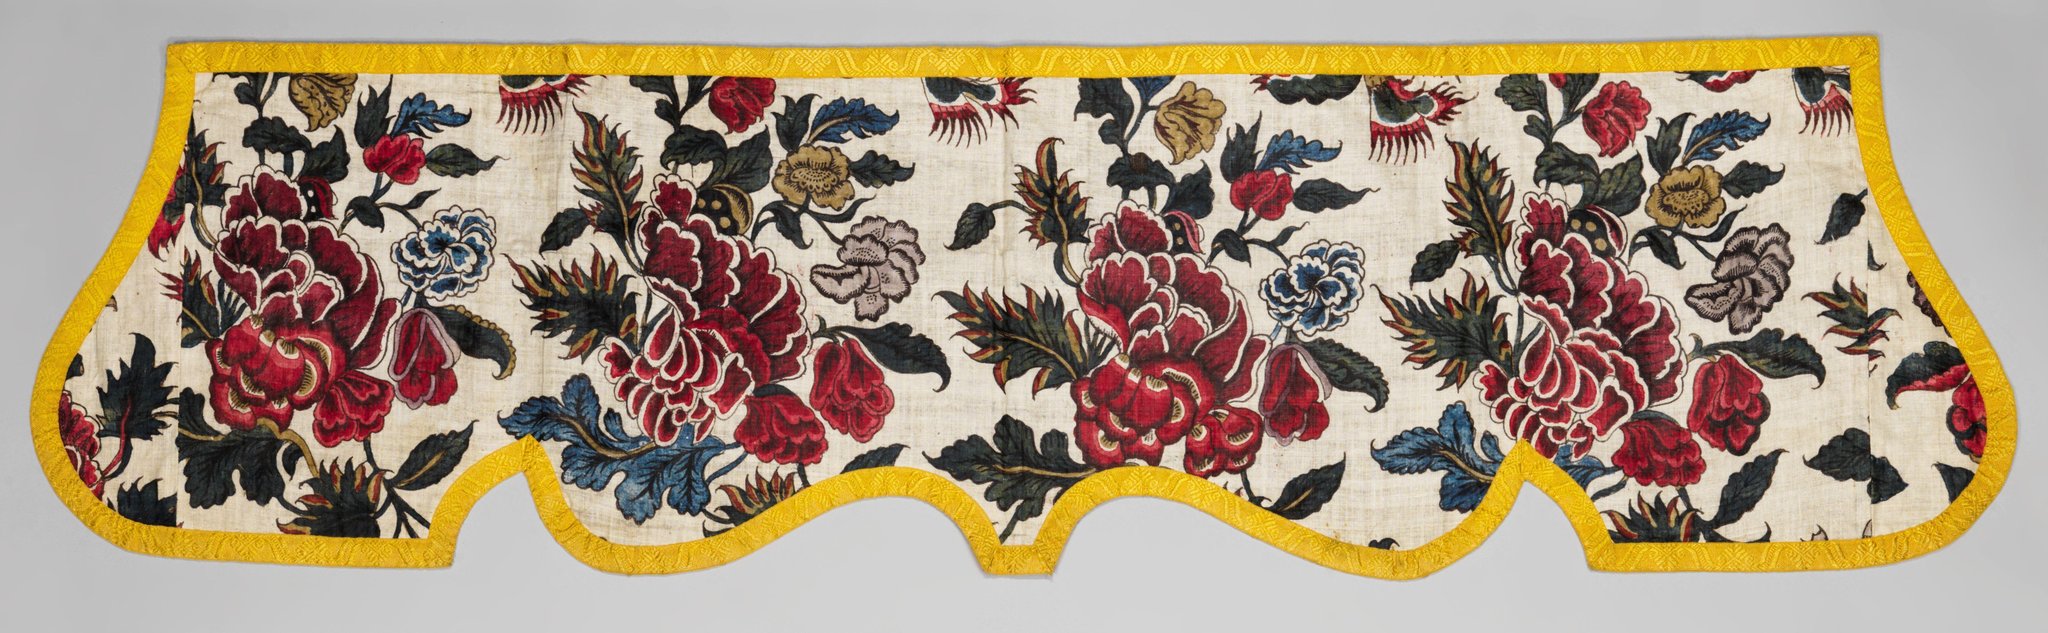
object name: lambrequin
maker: Anonymous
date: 1735-1740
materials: cotton, paint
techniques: painted, weave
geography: coromandel coast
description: The technical virtuosity of this lambrequin – a draped decoration – is simply astonishing. It came from Twickel Castle near Delden (province of Overijssel) and may have served as a lampshade or the decoration the edge of a bed. The room in which the bed stood may have been decorated entirely in chintz as well. Chintz remained in use in the Netherlands, even at court, throughout the 18th century.